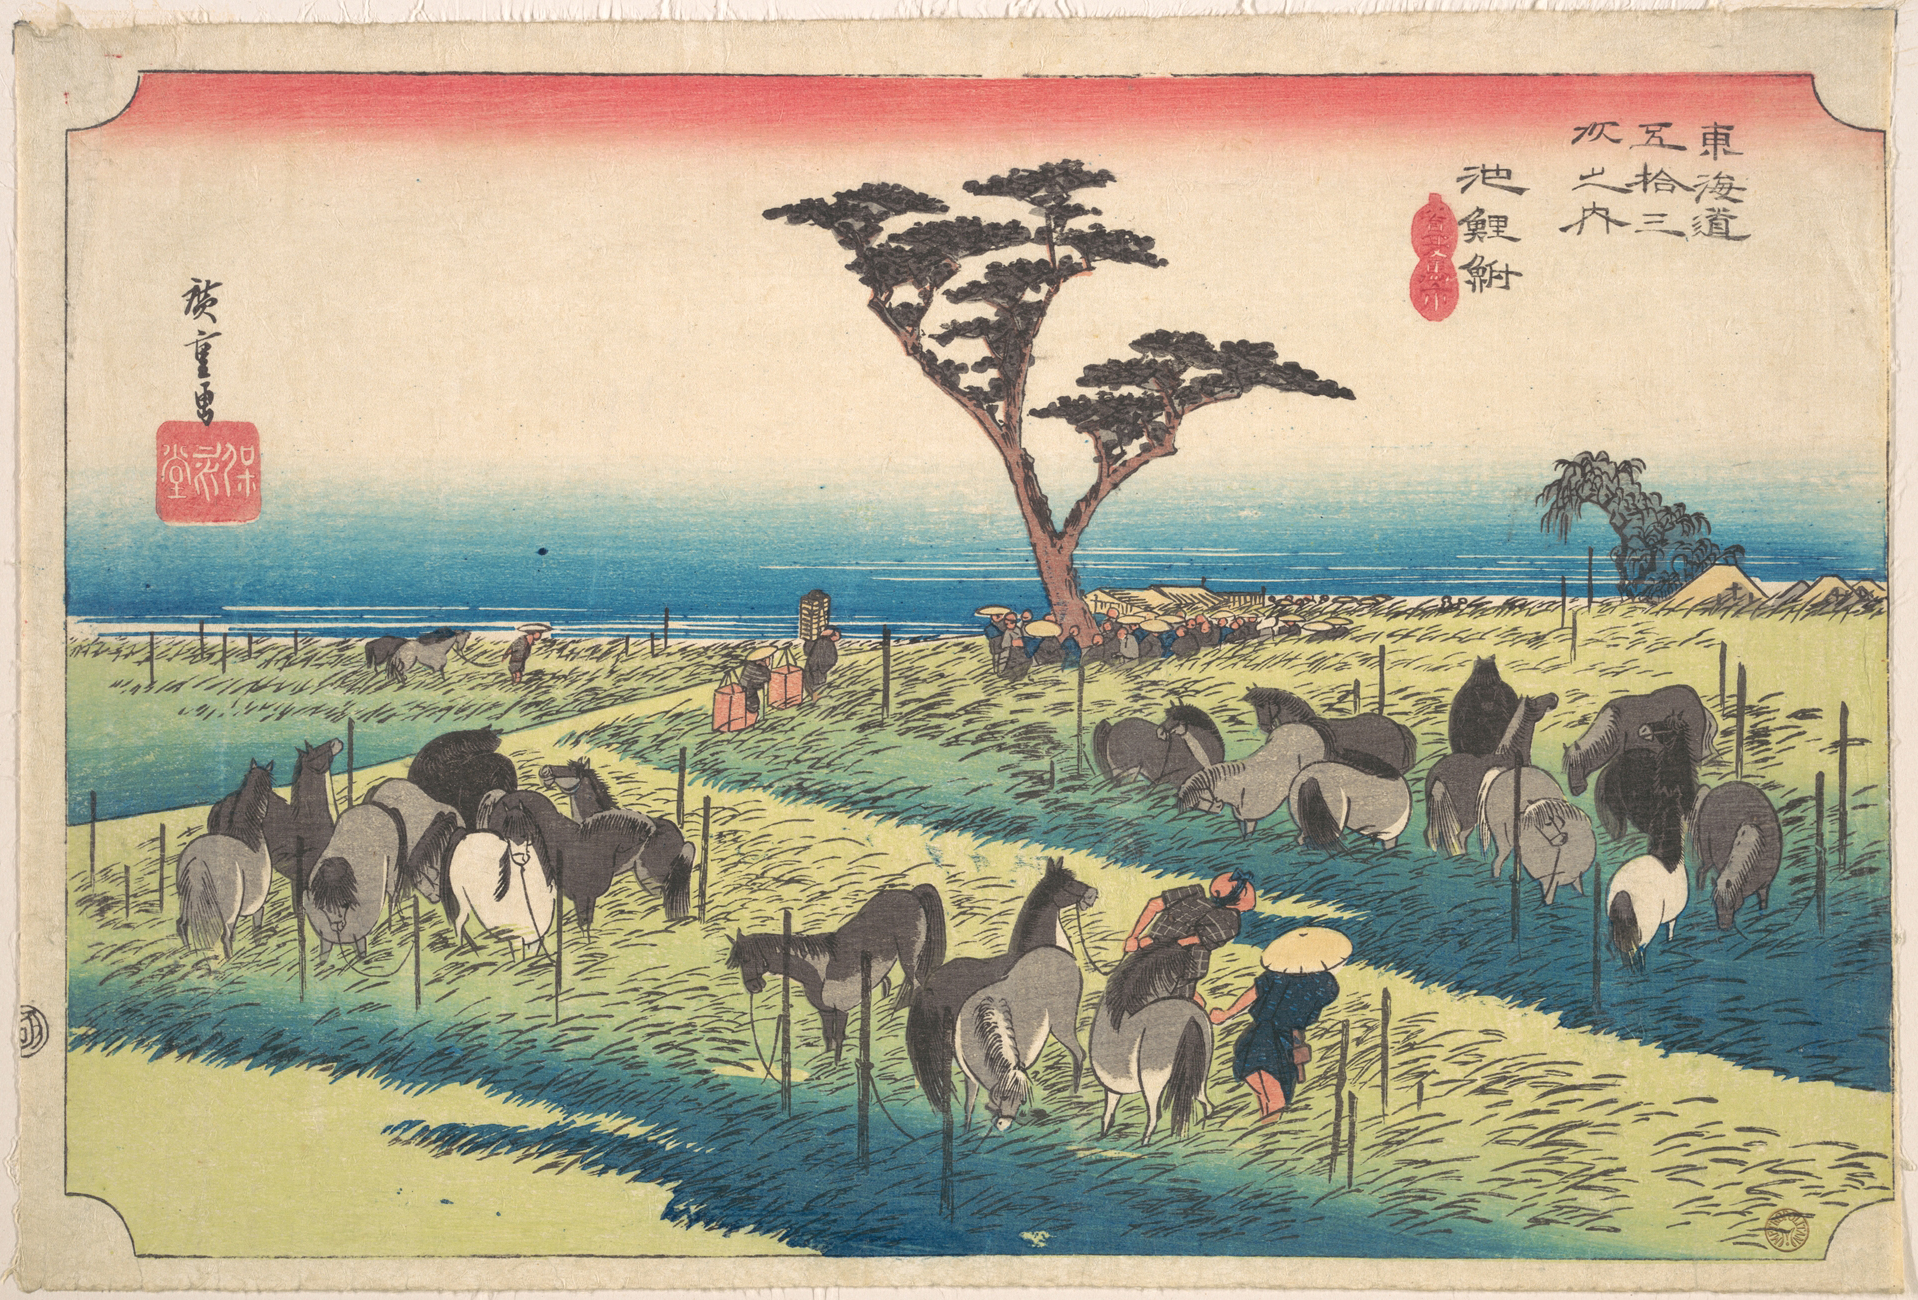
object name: print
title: Chiryu, Shuka Uma Ichi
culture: japanese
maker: utagawa hiroshige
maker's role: artist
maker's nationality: japanese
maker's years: 1797-1858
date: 1834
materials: ink, paper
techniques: woodblock print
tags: human figures,horses